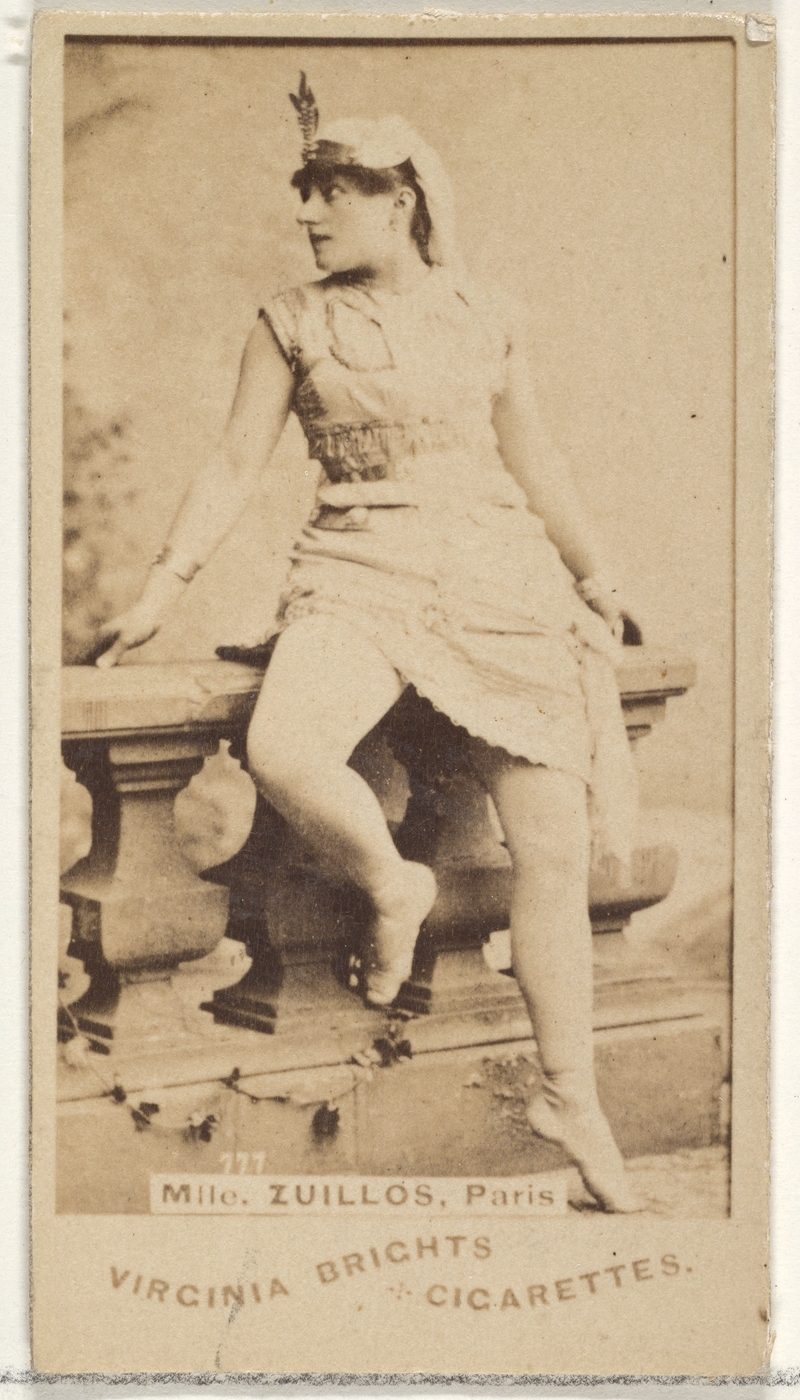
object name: photograph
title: Mlle. Zuillos, Paris, from the Actors and Actresses series (N45, Type 1) for Virginia Brights Cigarettes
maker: allen & ginter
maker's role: publisher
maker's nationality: american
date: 1888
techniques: albumen silver print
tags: portraits,women,actresses